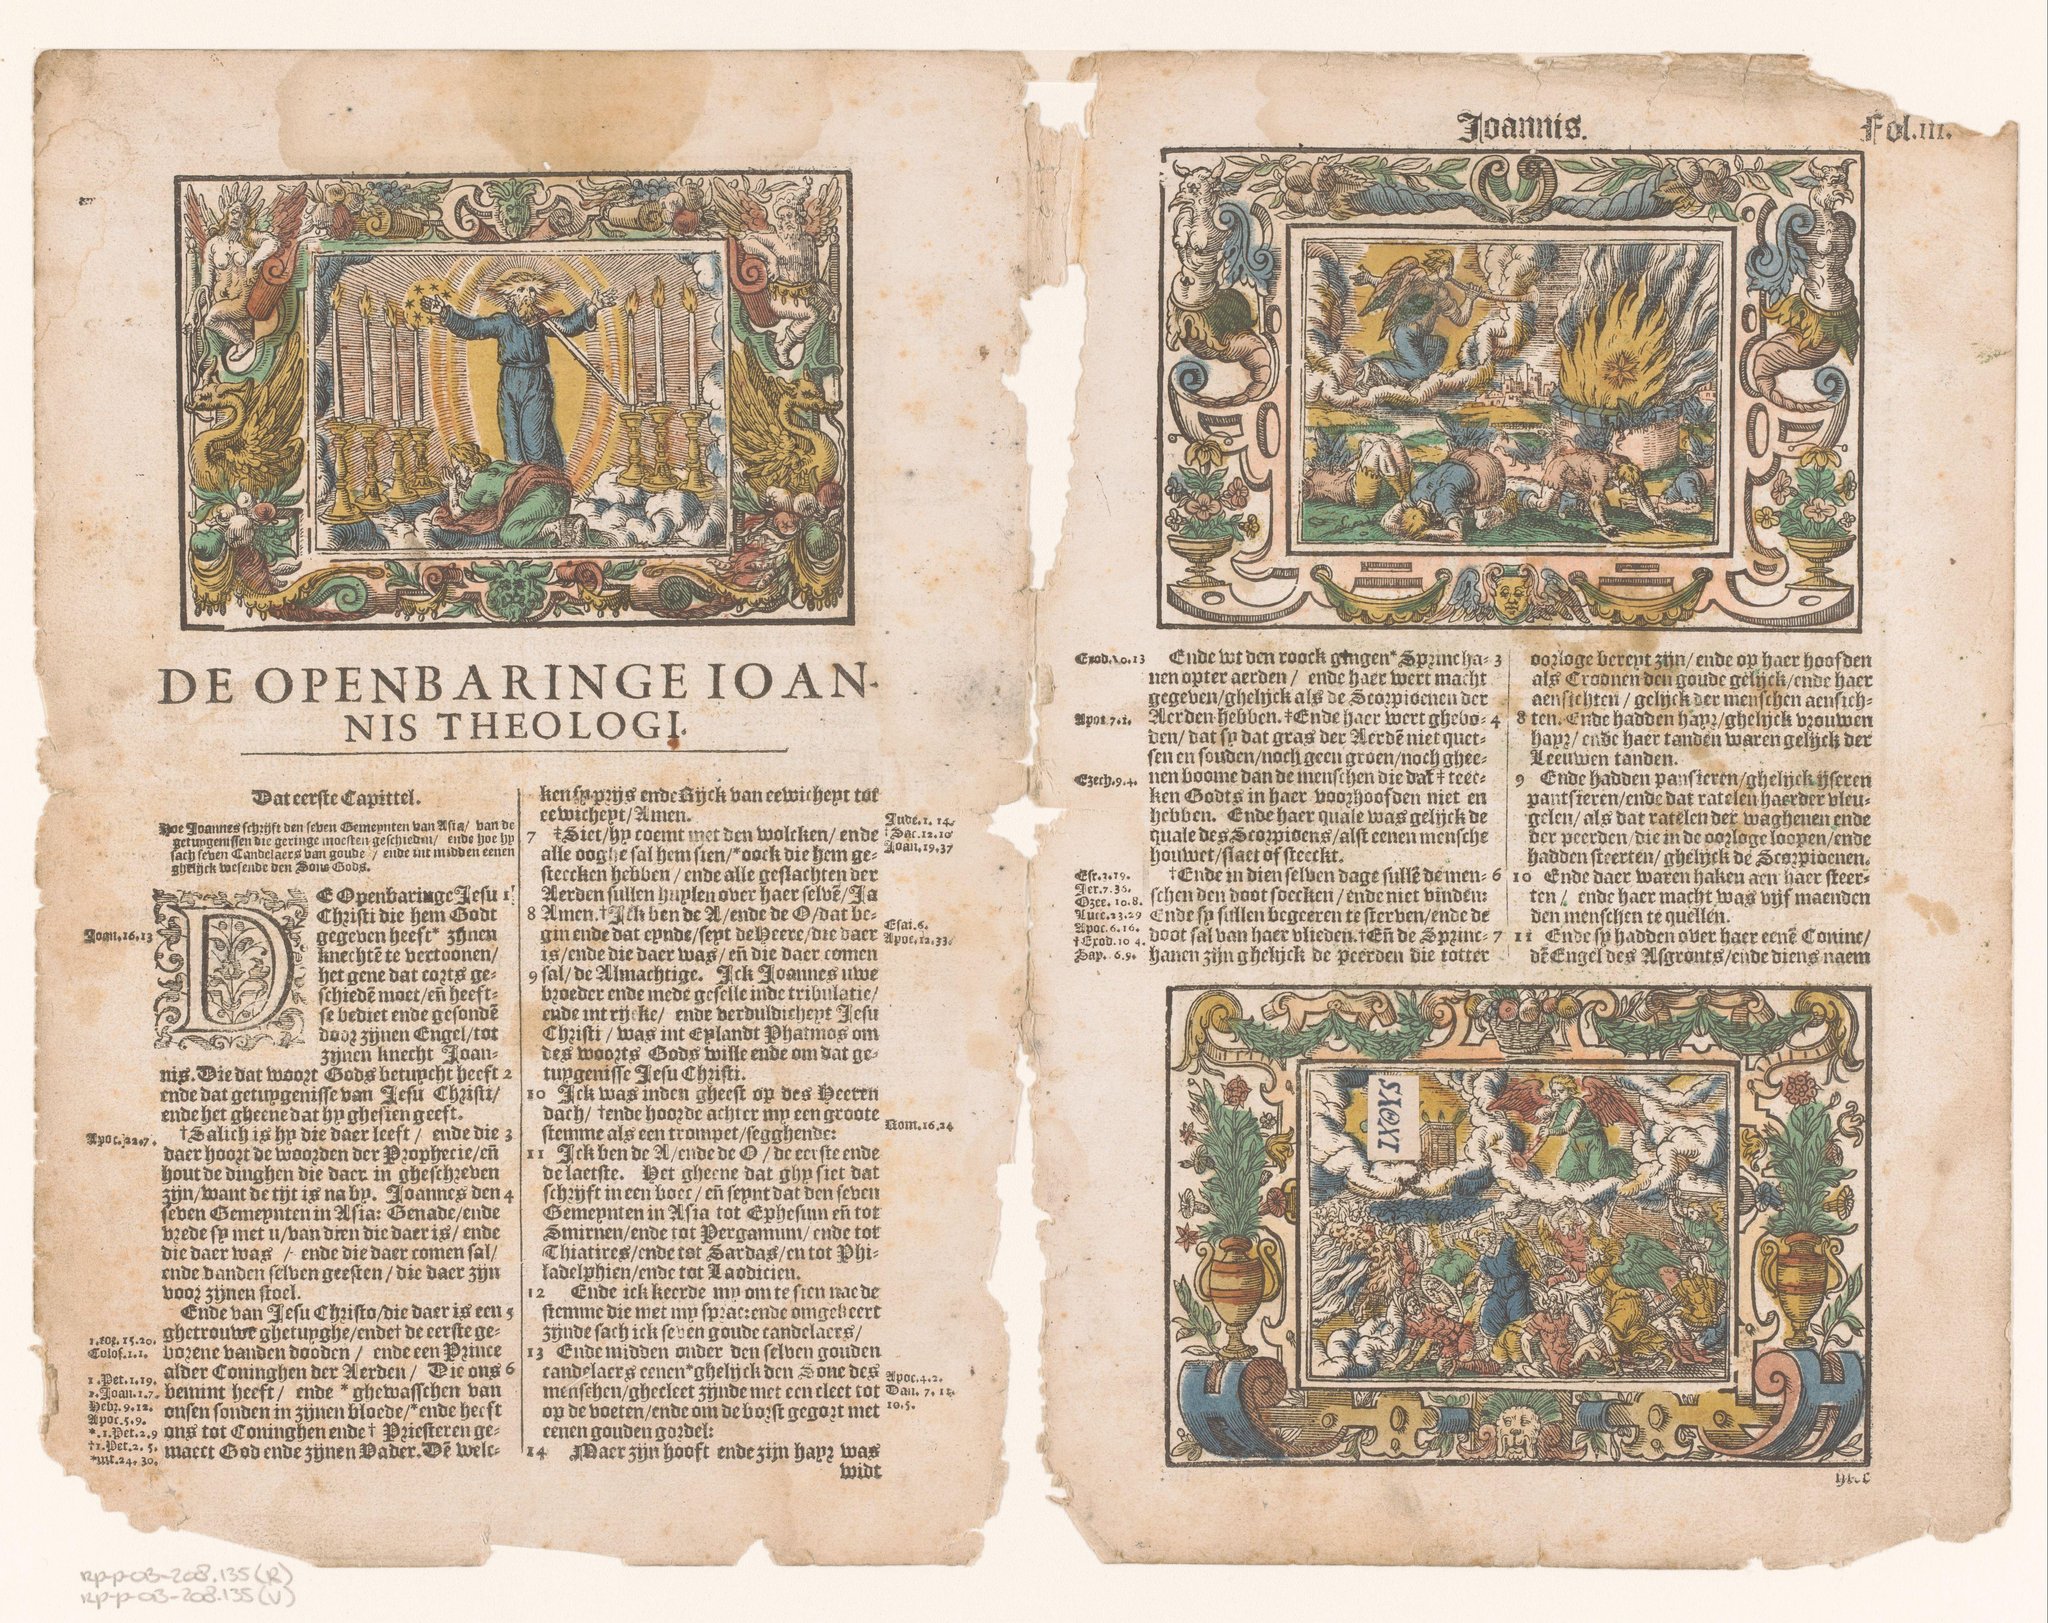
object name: print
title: Drie voorstellingen uit de Openbaring van Johannes (Apocalyps)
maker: Anonymous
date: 1600-1699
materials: paper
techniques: hand coloring, letterpress printing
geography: netherlands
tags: the revelation of john, the apocalypse, christ between seven golden candlesticks appears to john, who falls to the ground; a sword comes out of christ's mouth and he holds seven stars in his hands, the plague of the monstrous locusts with crowns, led by apollyon, the fifth of the seven angels sounds the trumpet: the falling star opens up the bottomless pit: smoke comes out, the army of horsemen ~ the seven angels with trumpets, the sixth of the seven angels sounds the trumpet: the four angels of destruction are released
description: Het visioen van de zeven gouden lampenstandaards, de vijfde engel blaast op de bazuin en de zesde engel blaast op de bazuin.